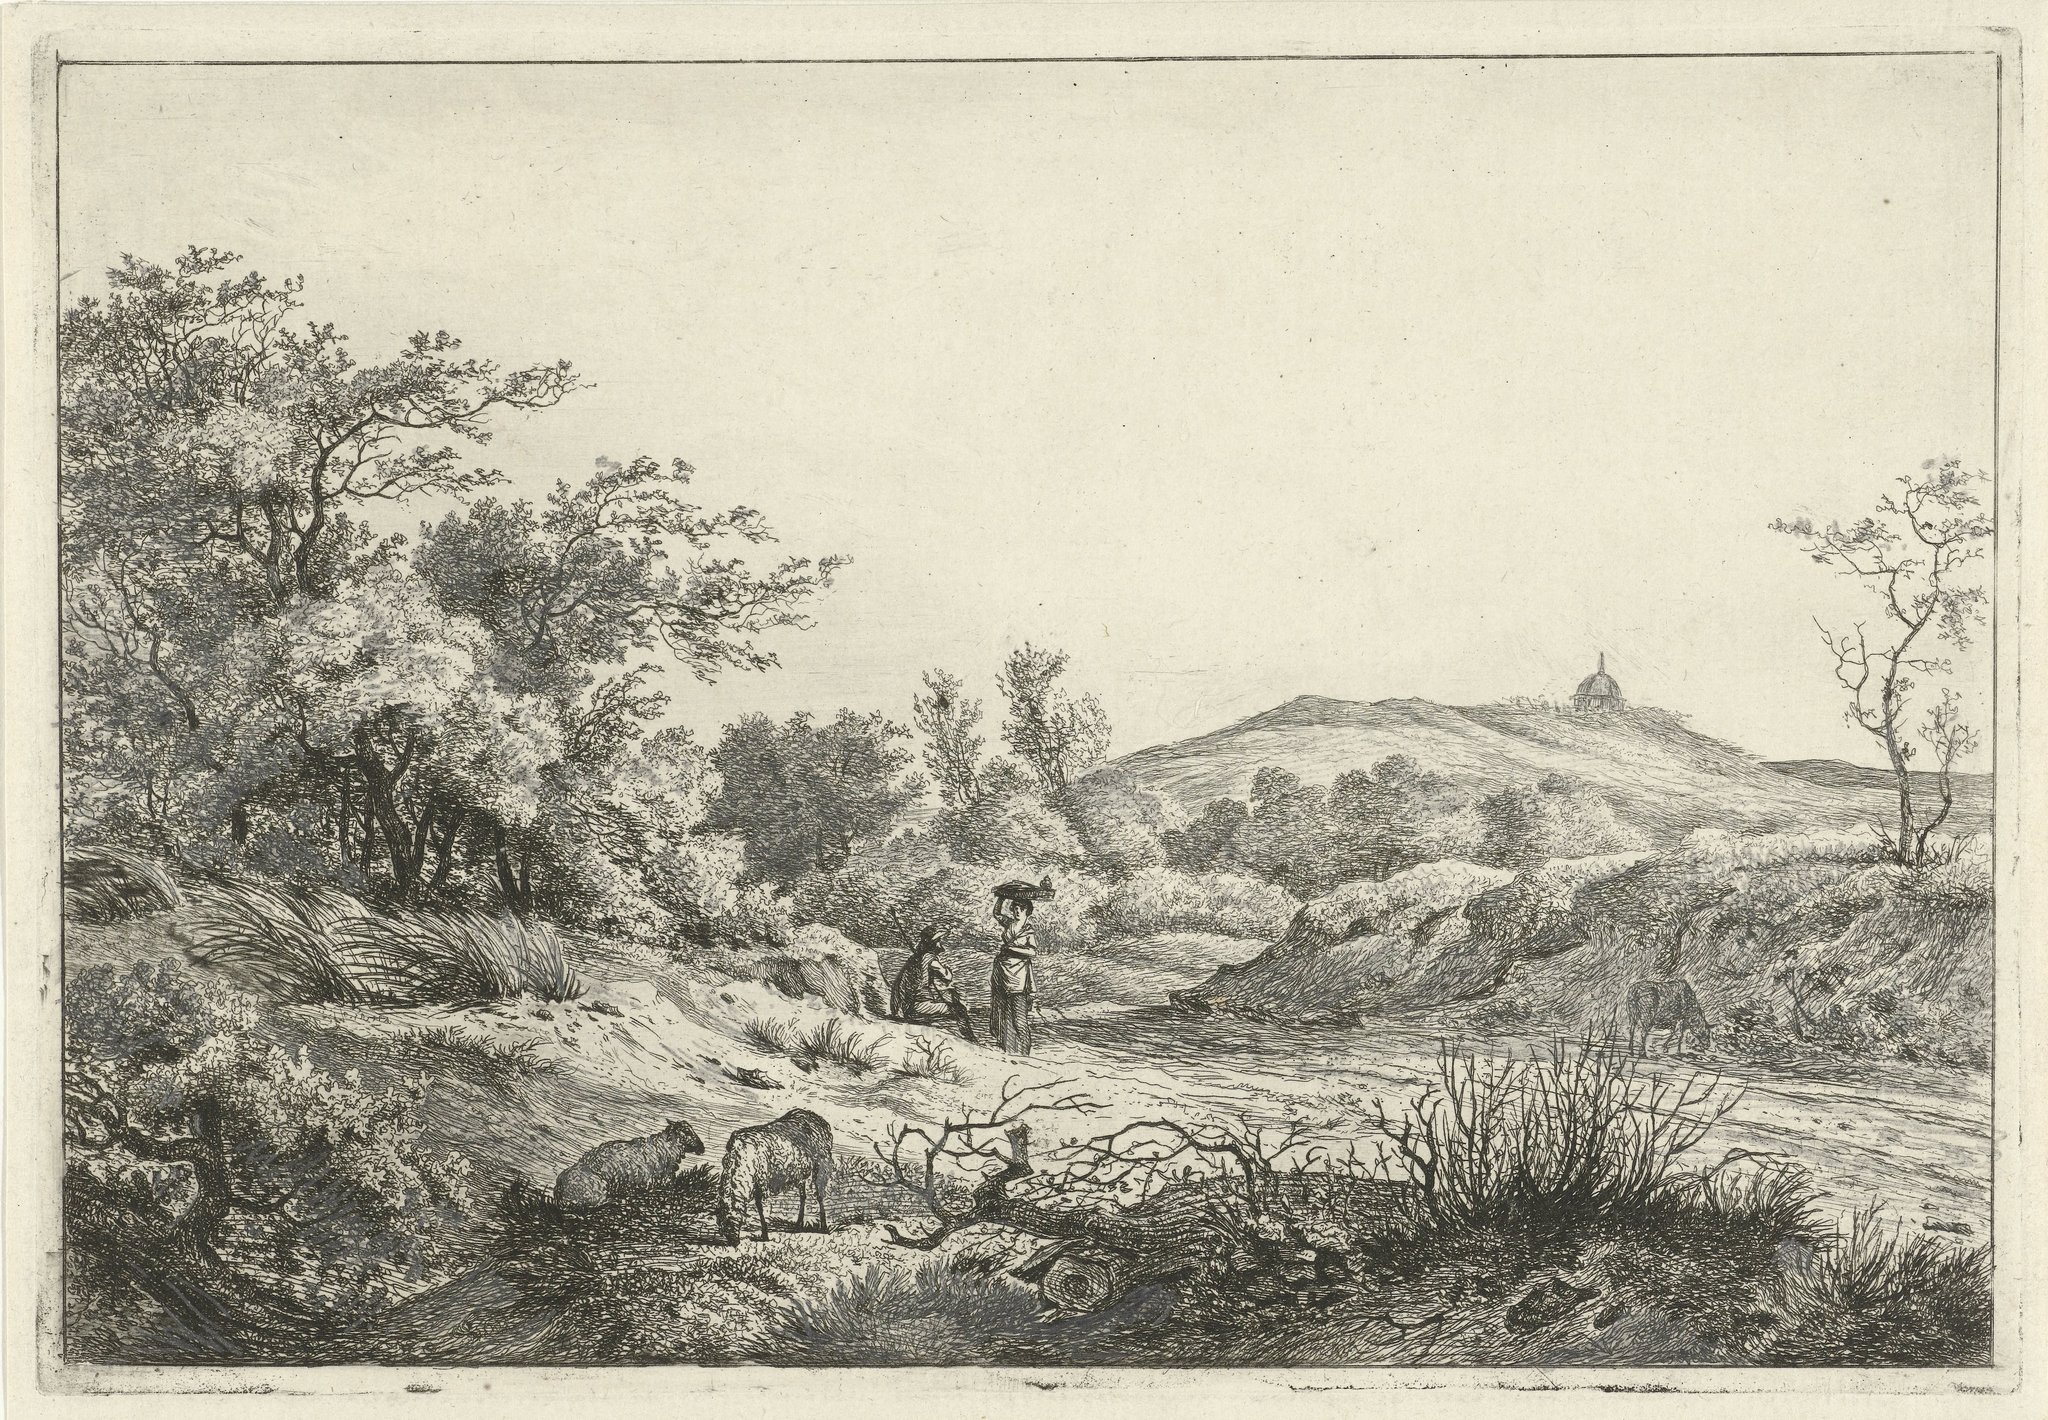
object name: print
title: Landschap met herder en vrouw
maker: hermanus fock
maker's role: conservator, draughtsman, painter, print maker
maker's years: 1766-1822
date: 1781-1822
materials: paper, pencil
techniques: etching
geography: amsterdam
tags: herding, herdsman, herdswoman, shepherd, shepherdess, cowherd, etc., low hill country (+ landscape with figures, staffage)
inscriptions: collector's mark: Lugt 2228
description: Heuvellandschap met op de voorgrond twee schapen. Een vrouw met een mand op haar hoofd staat bij een zittende herder. Op de achtergrond een koepelgebouw op een heuvel.